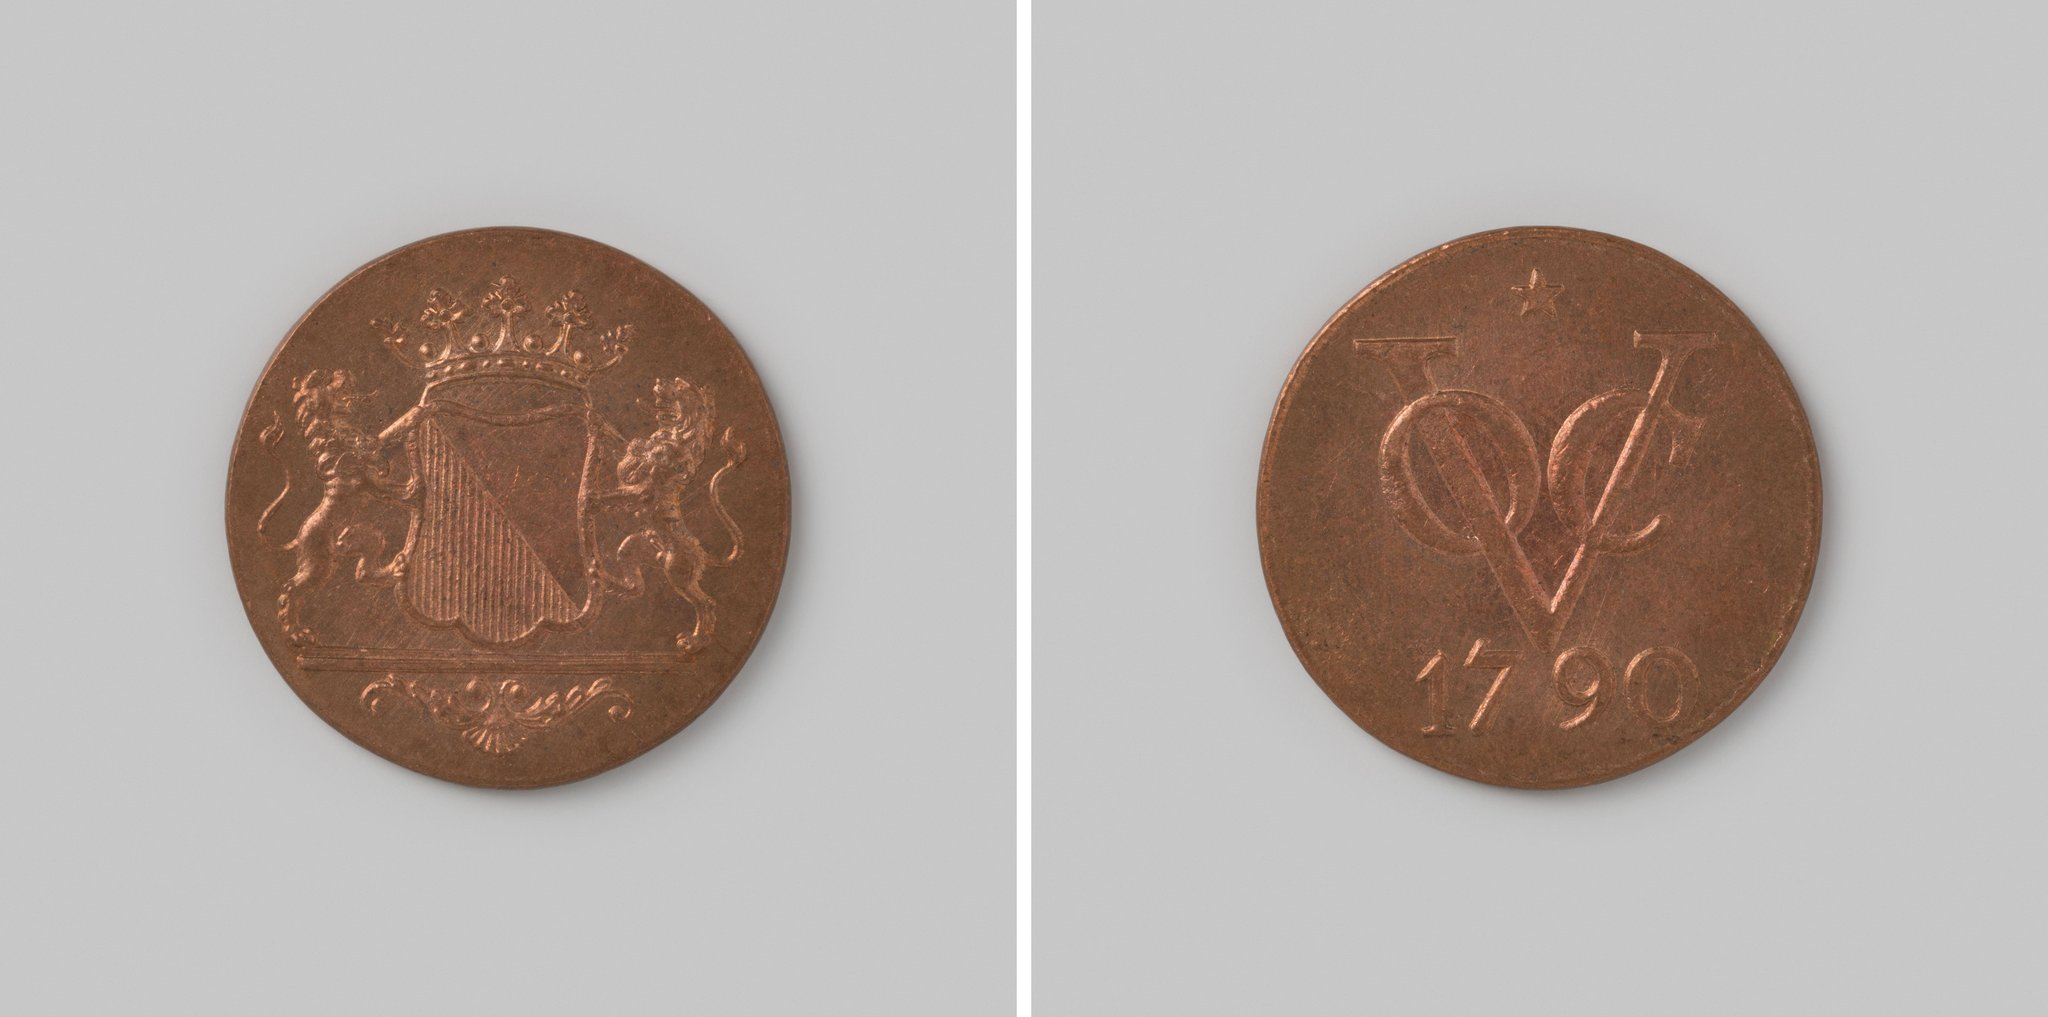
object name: coin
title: Dubbele duit van de VOC op naam van de stad Utrecht met jaartal 1790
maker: william ii of the netherlands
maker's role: koning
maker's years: 1792-1849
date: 1840-1843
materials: copper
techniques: striking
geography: surabaya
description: Koperen munt. Voorzijde: op balk, waaronder guirlande, staand, door twee leeuwen gehouden gekroond wapenschild van de stad Utrecht. Keerzijde: monogram van de VOC, waarboven muntteken ster en waaronder fictief jaartal 1790. Gladde rand.